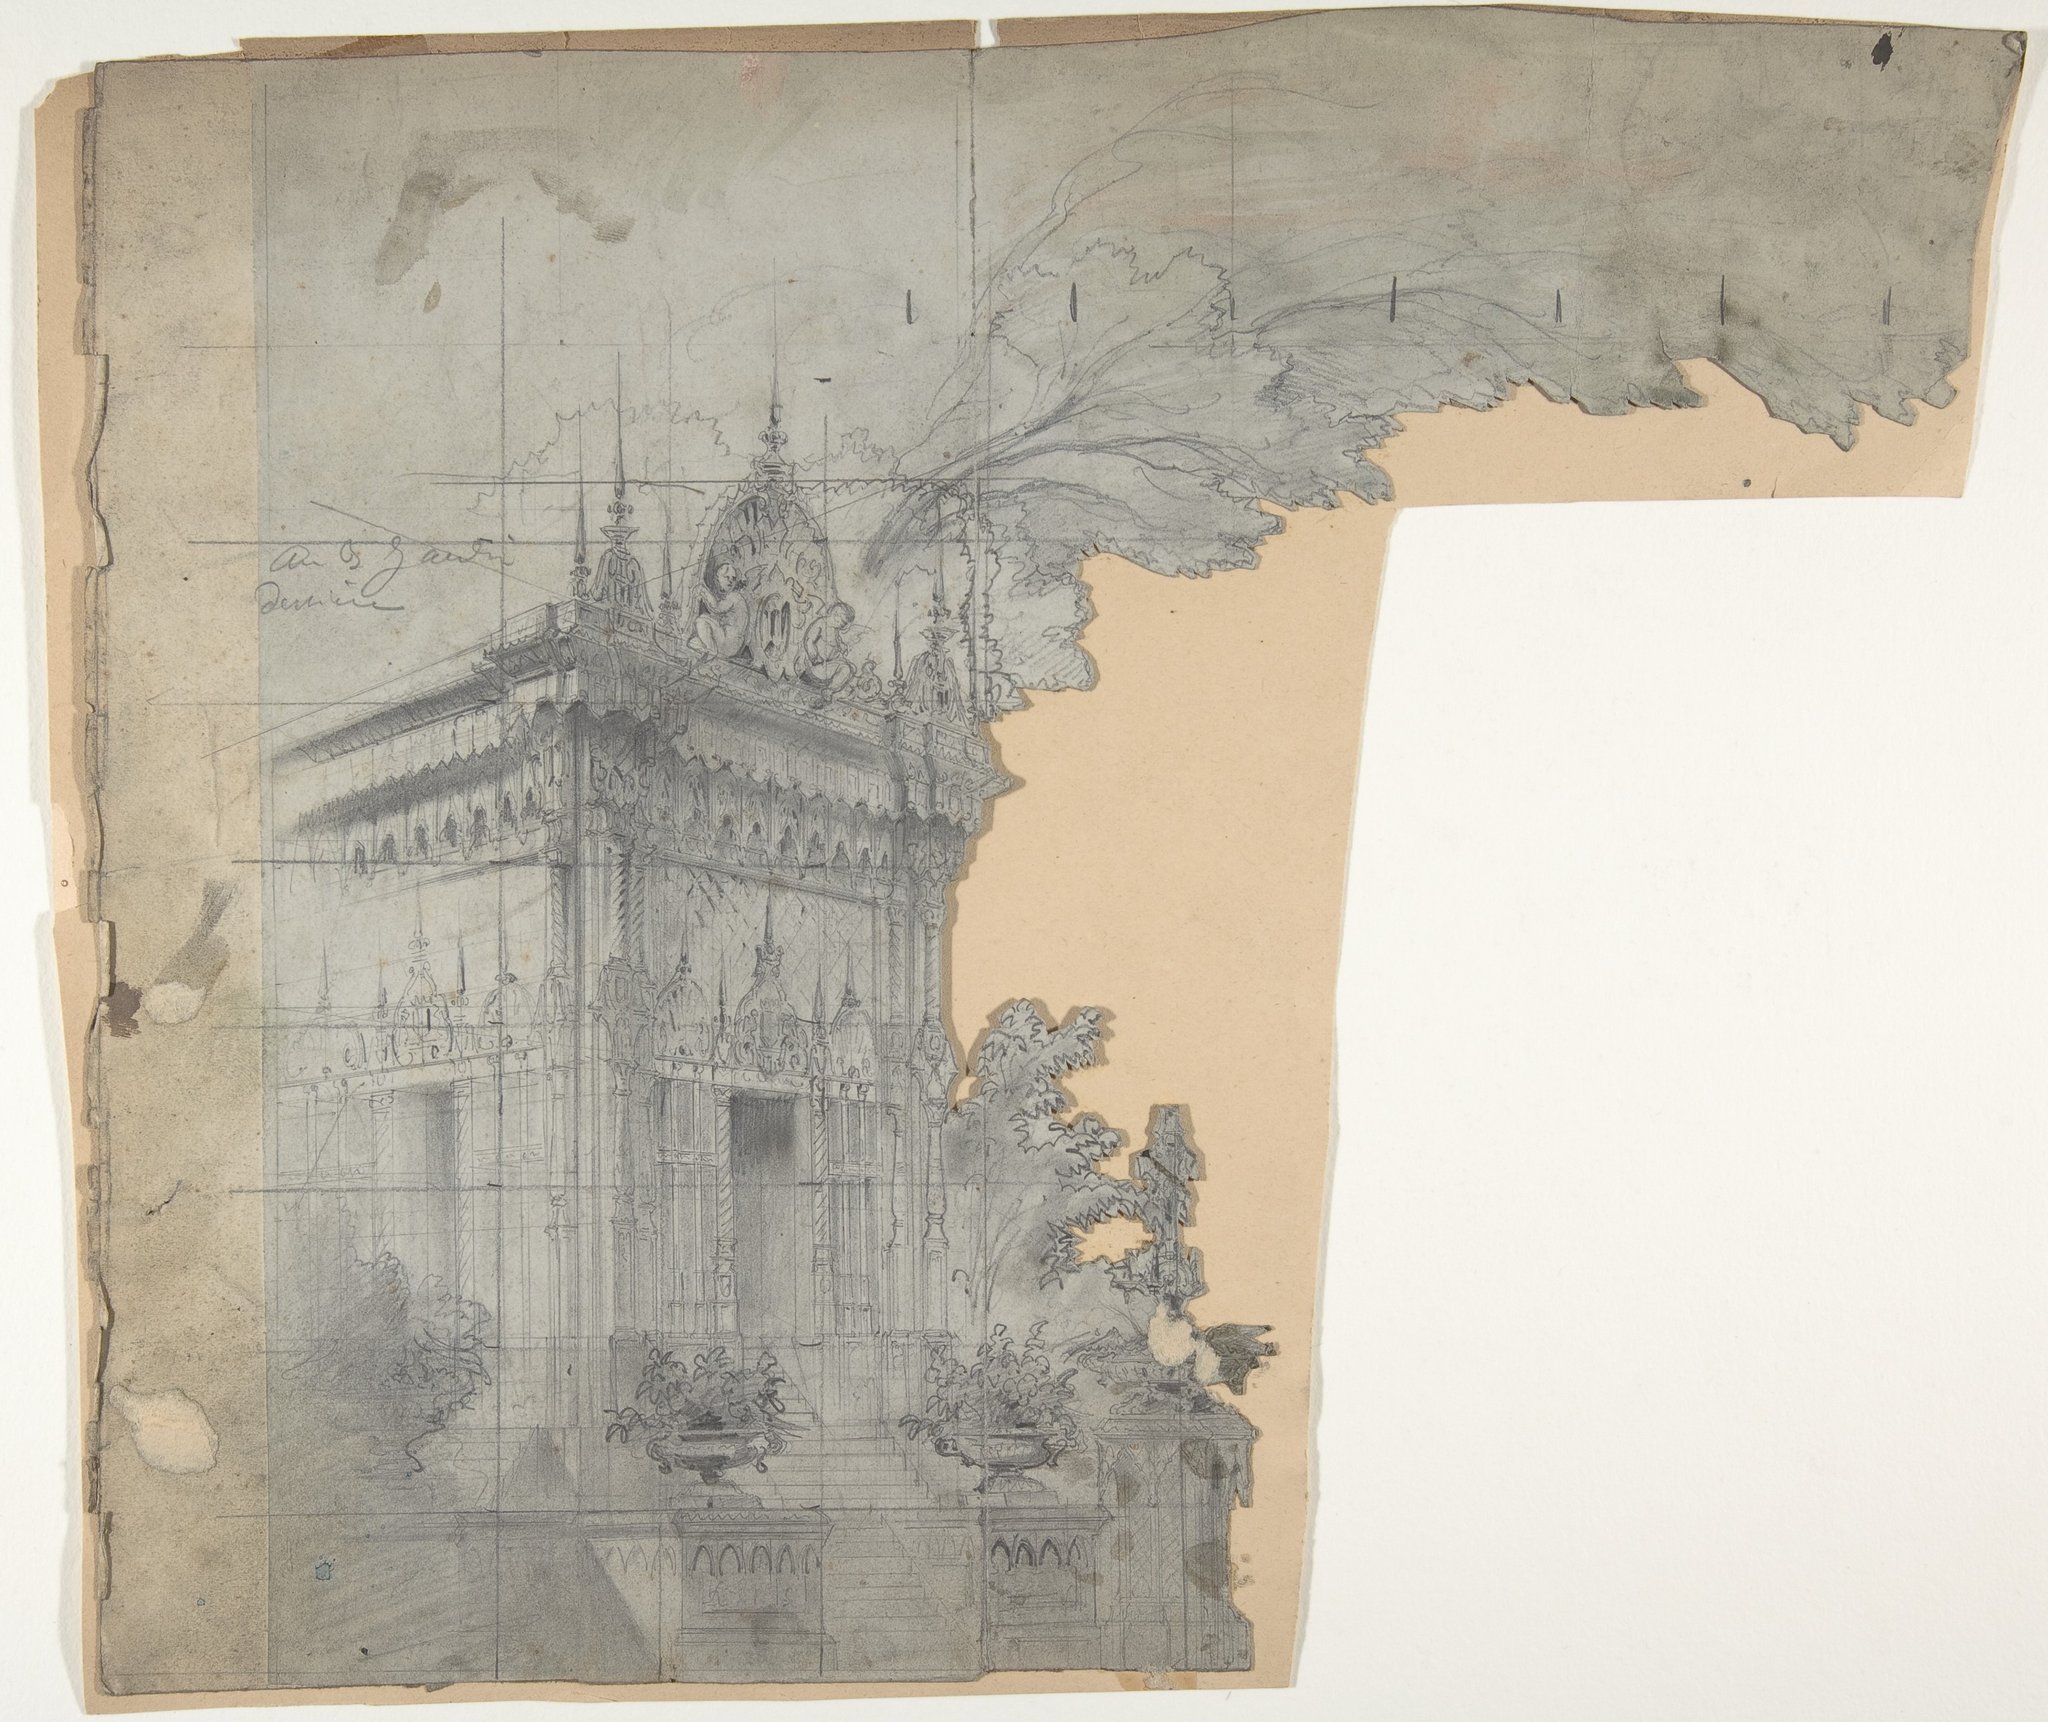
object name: drawing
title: Design for a Stage Set at the Opéra, Paris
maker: eugène cicéri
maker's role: artist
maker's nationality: french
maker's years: 1813-1890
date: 1840-1890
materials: graphite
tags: buildings,stage design